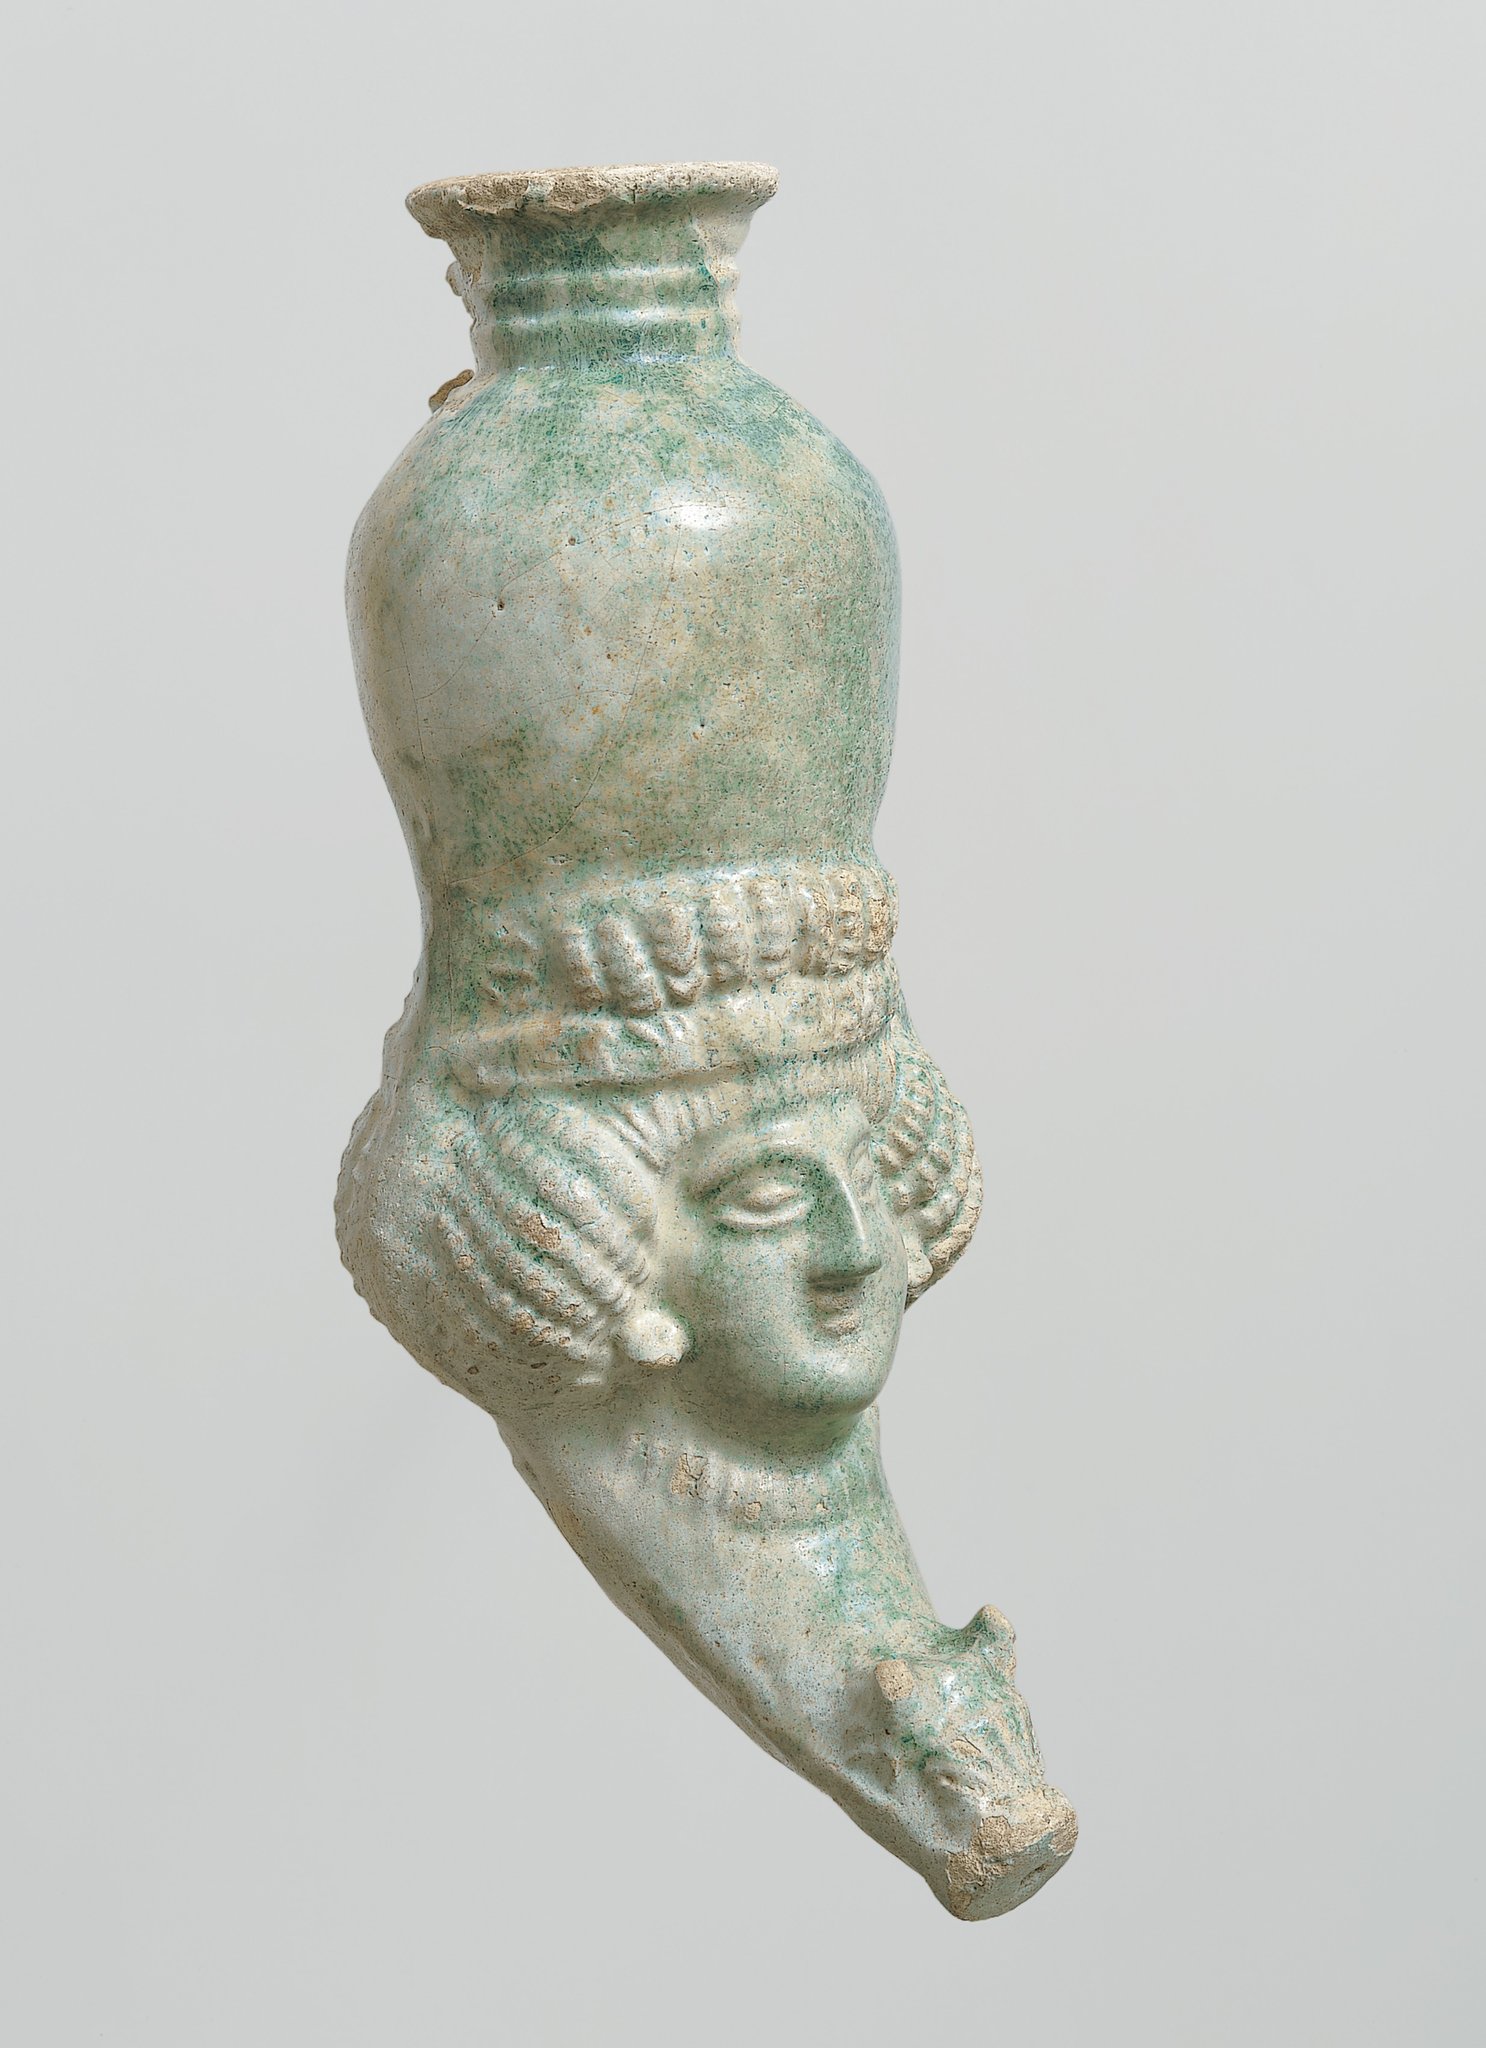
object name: rhyton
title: Rhyton with female head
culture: parthian or sasanian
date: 201-300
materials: ceramic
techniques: glazing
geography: mesopotamia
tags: heads,women